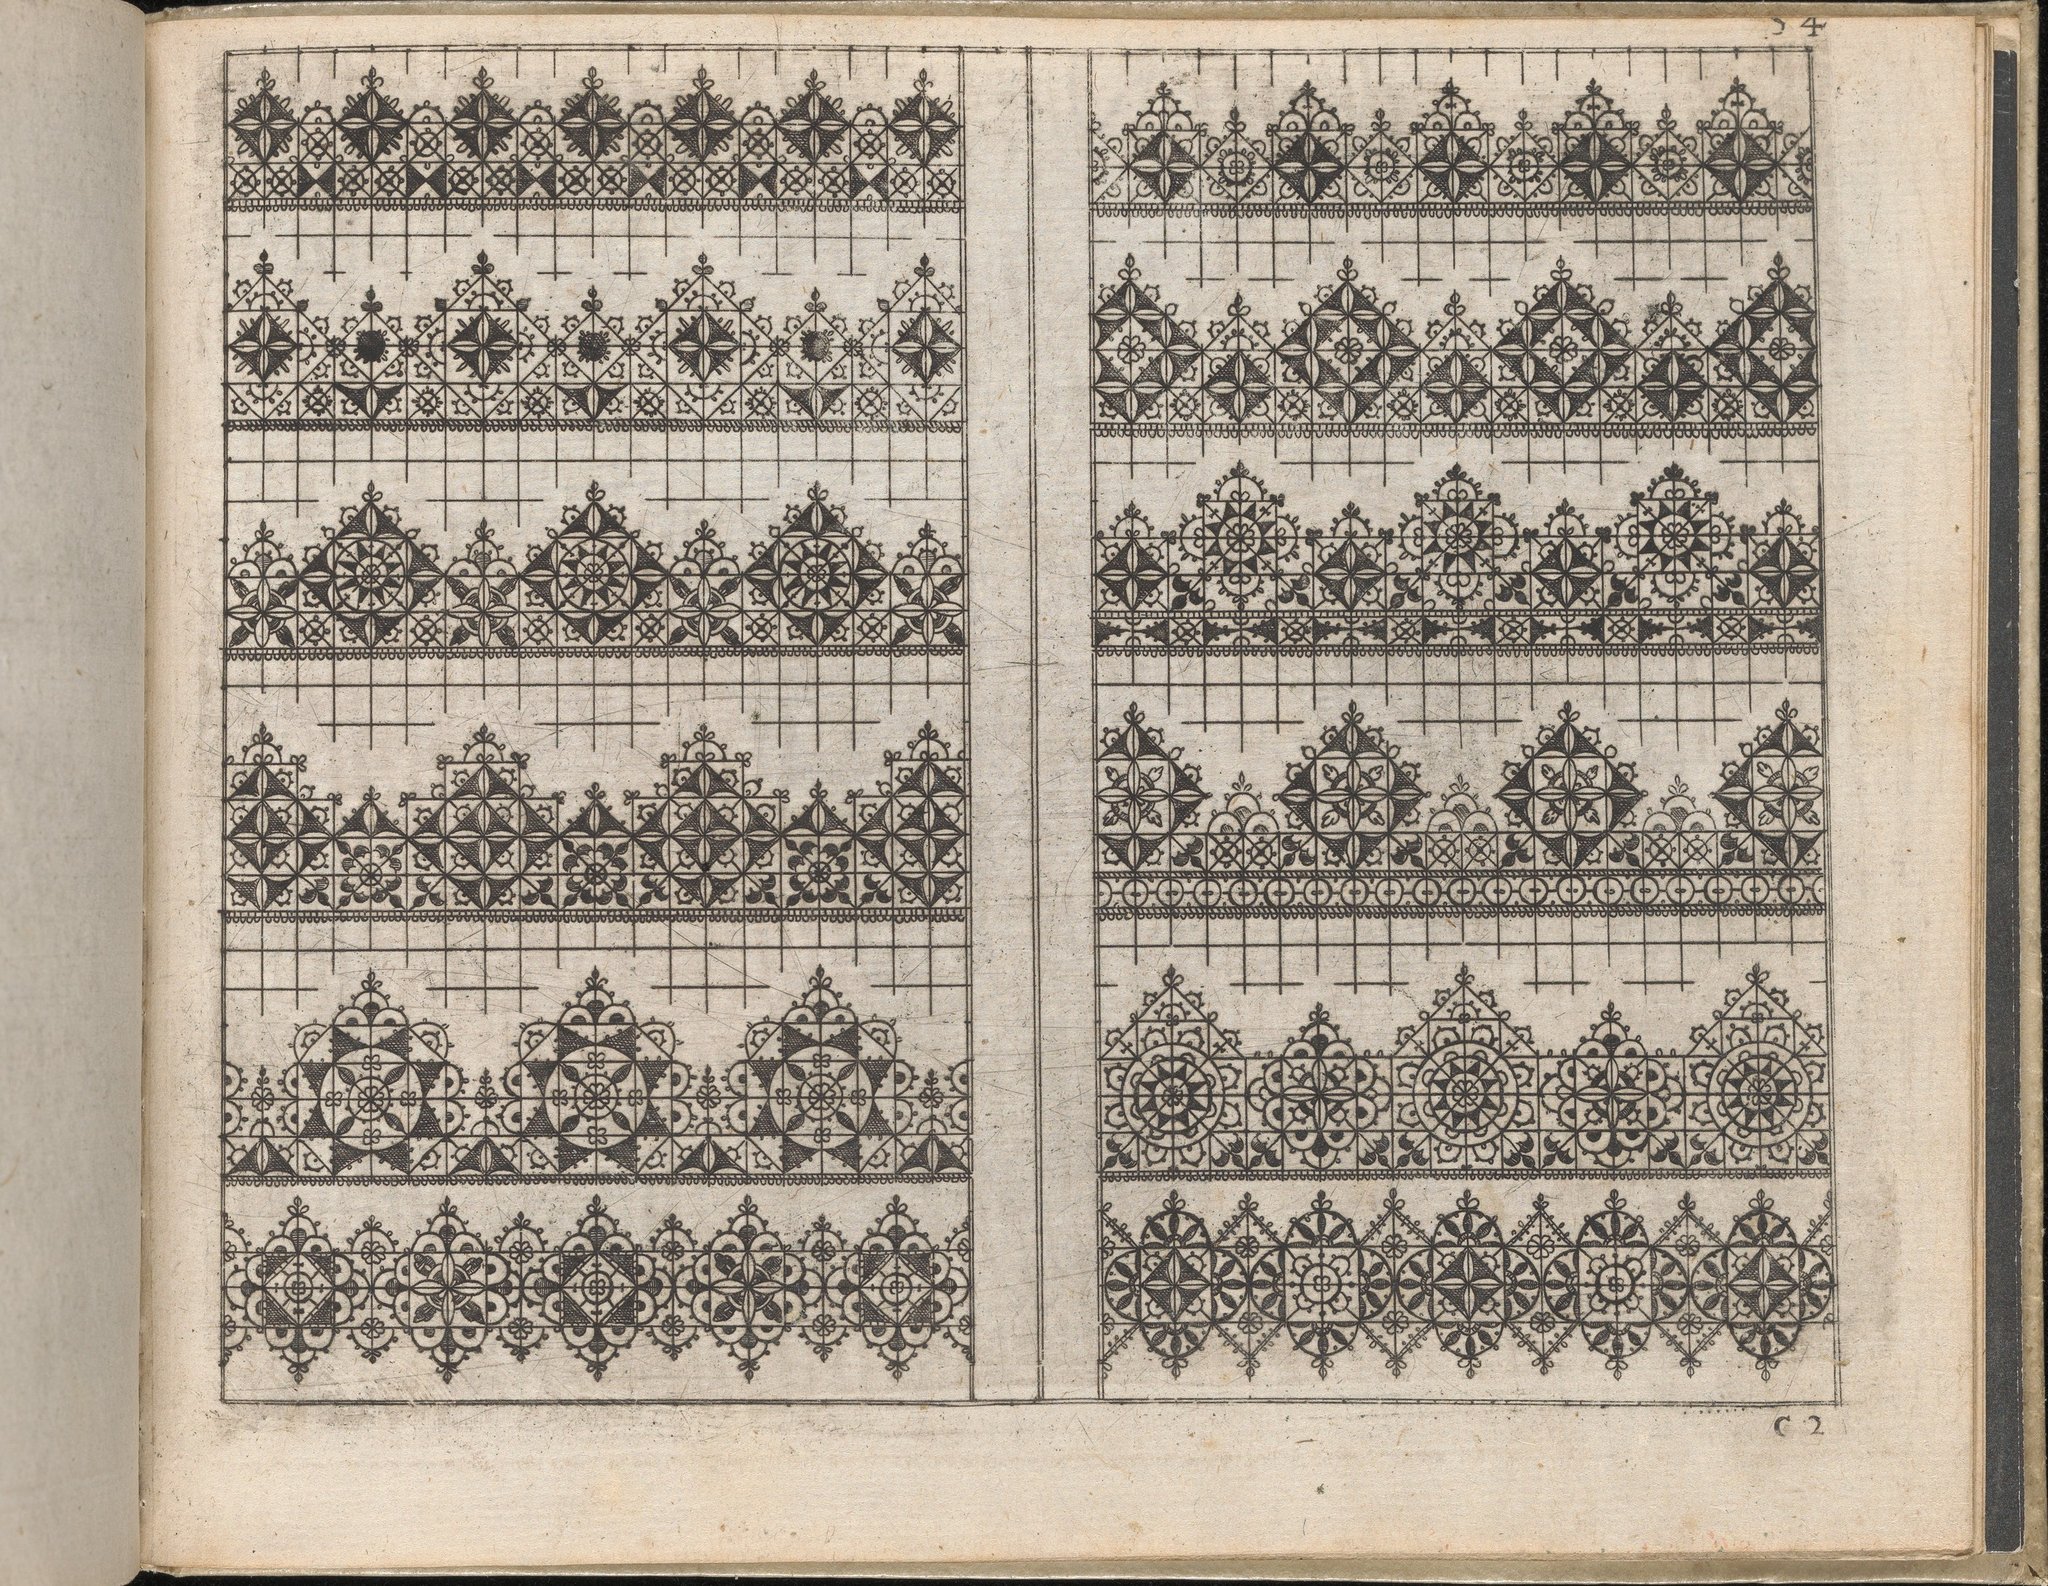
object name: book print ornament architecture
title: Newes Modelbuch in Kupffer (Page 62r)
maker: johann sibmacher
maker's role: artist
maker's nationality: german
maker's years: 1590-1611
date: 1604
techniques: etching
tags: ornament